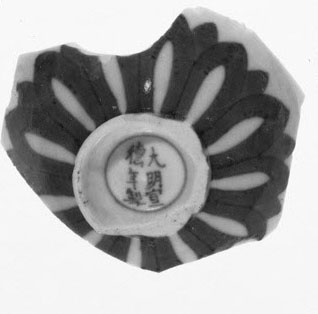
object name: fragment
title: Fragment of a Bowl (Study Collection)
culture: chinese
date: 1644-1911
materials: porcelain